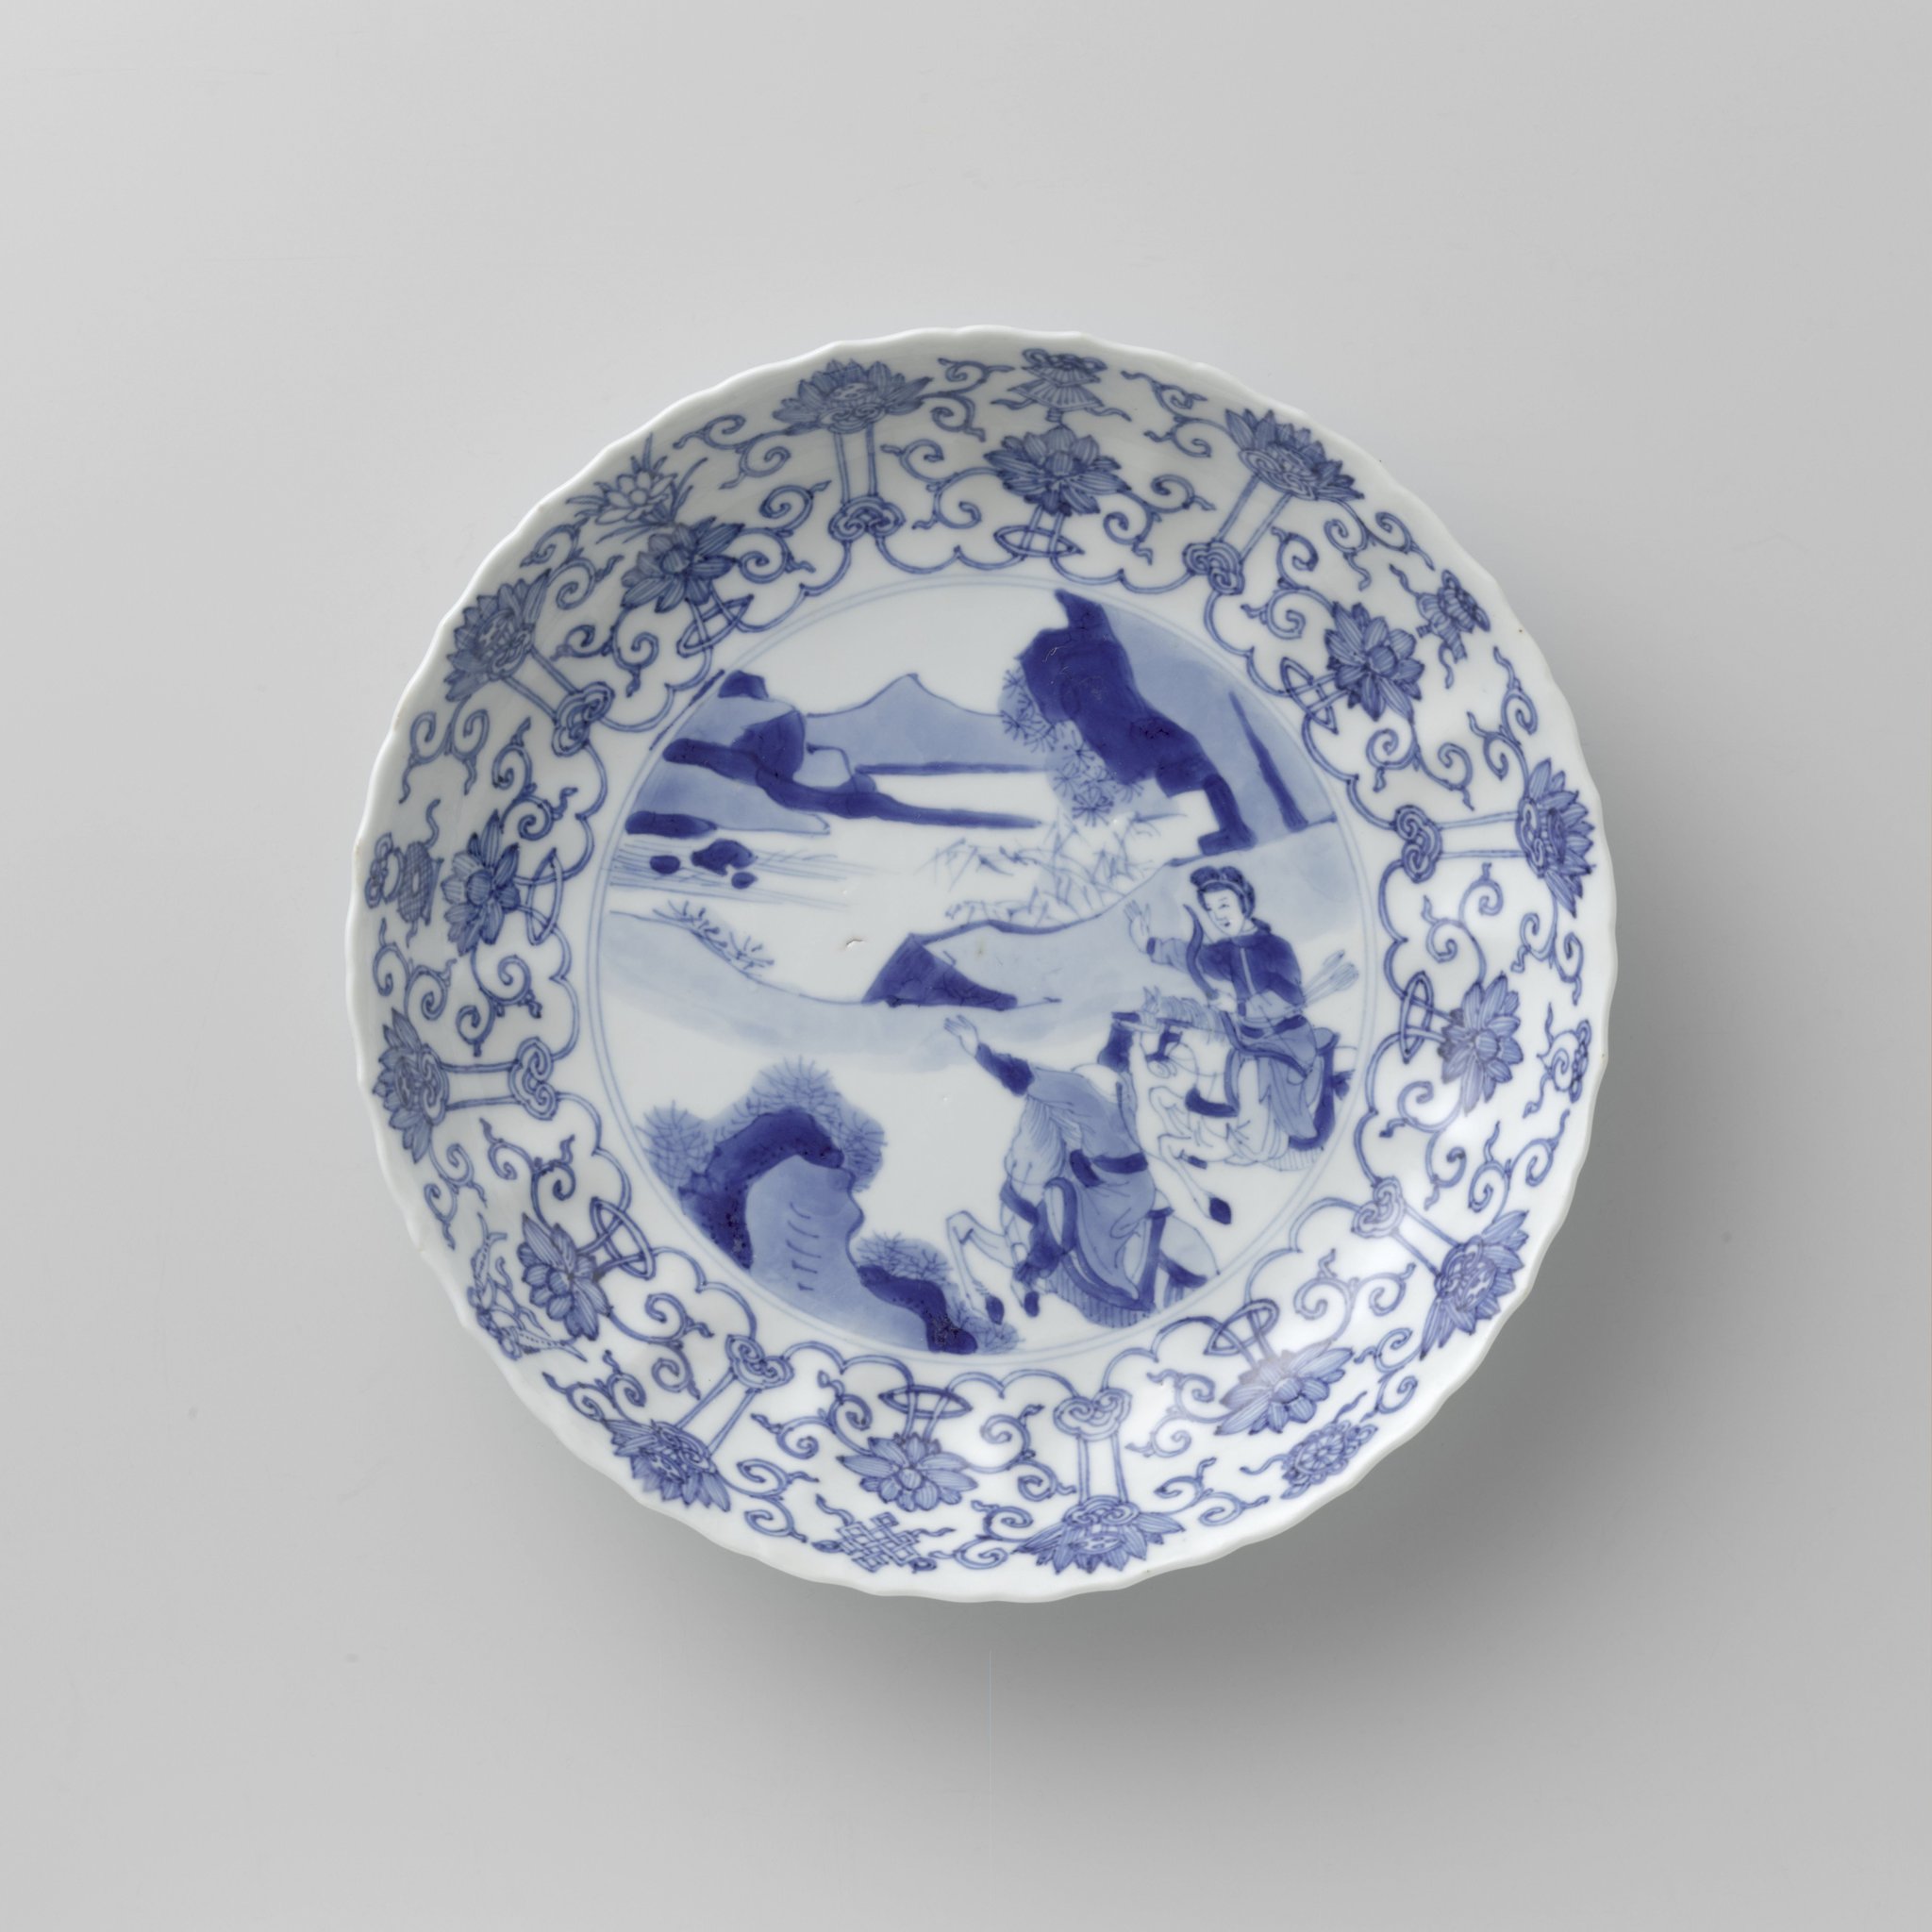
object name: dish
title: Saucer-dish with hunting scene, lotus scrolls and auspicious symbols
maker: Anonymous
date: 1700-1724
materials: cobalt, glaze, paint, porcelain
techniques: firing, forming, turning, vitrification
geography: china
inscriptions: mark: ‘大 明 成 化 年 製 dà míng Chéng huà nián zhì’